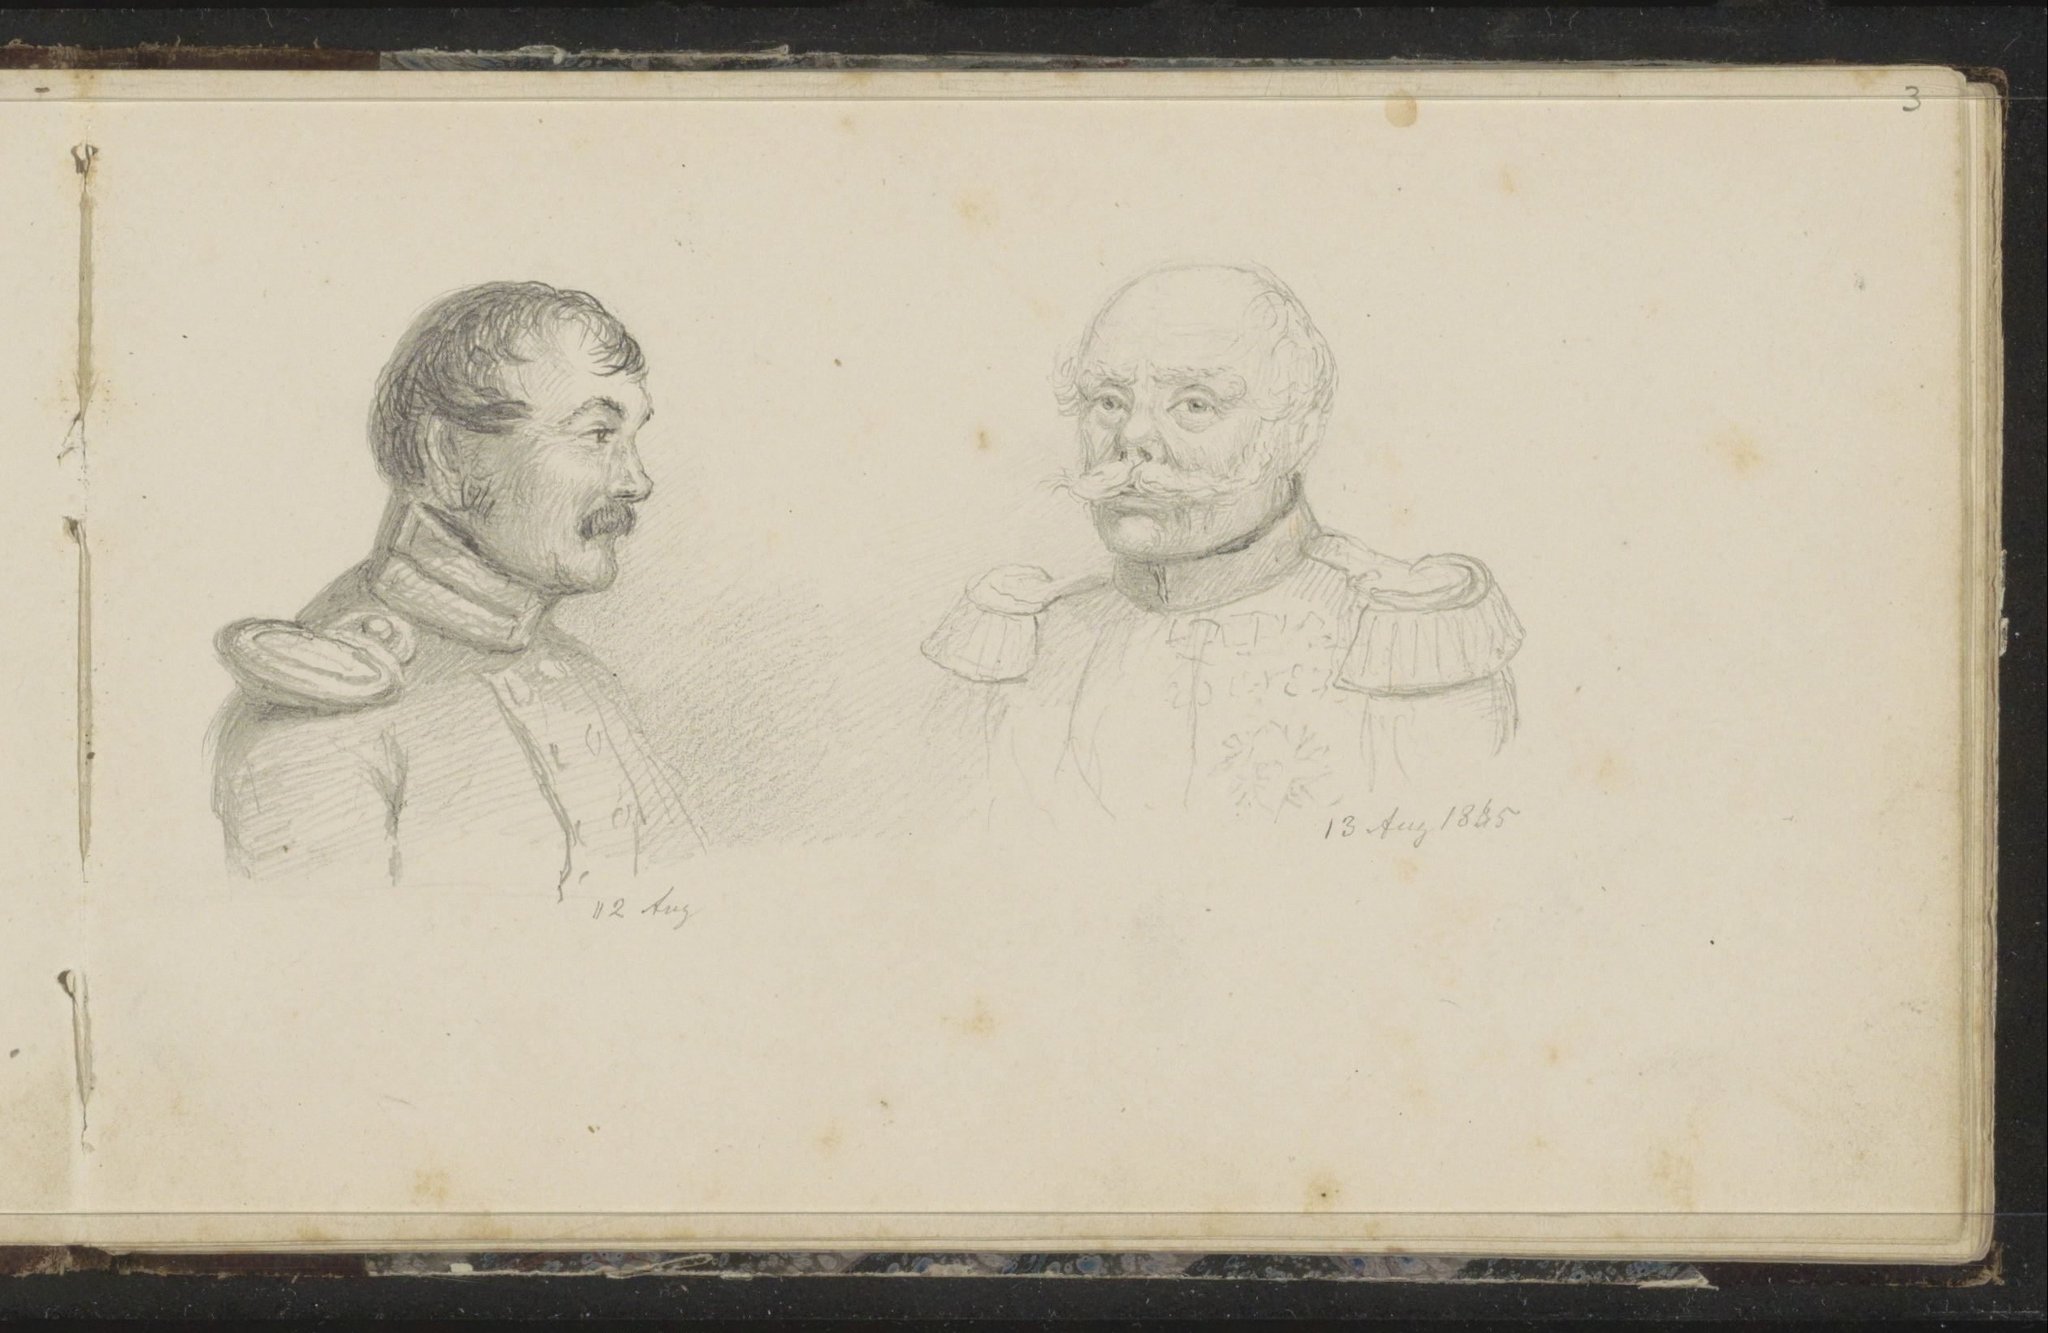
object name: sketchbook leaf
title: Portretten van twee militairen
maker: christian heinrich gottlieb steuerwald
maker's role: draughtsman, print maker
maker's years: 1802-1874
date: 1808-1845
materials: ink, paper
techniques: pen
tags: (military) uniforms, historical persons (portraits and scenes from the life)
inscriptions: date: ‘12 Aug/ 13 Aug. 1835’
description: Mogelijk portretten van militairen uit Hannover, volgend op de notities op blad 2. Blad 3 recto uit een schetsboek met 61 bladen.